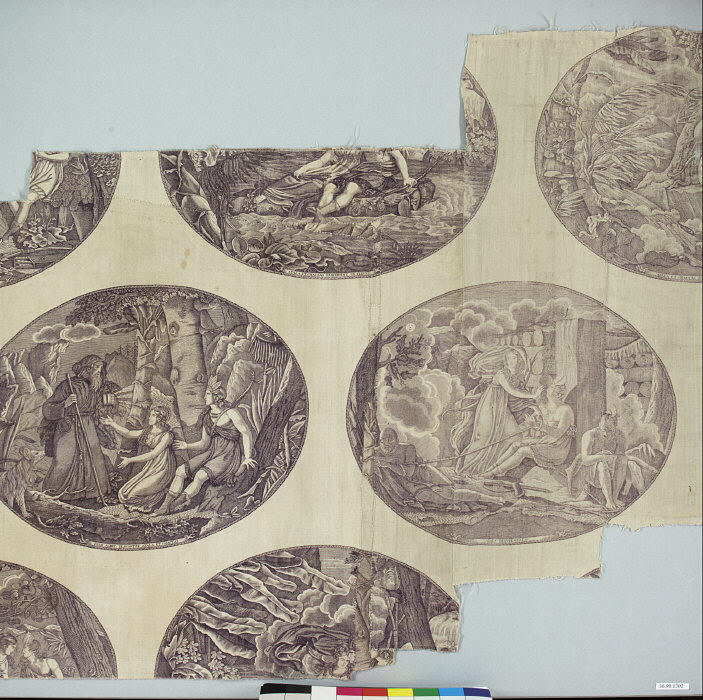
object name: piece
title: Atala and Chactas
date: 1801-1833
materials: cotton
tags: men,women